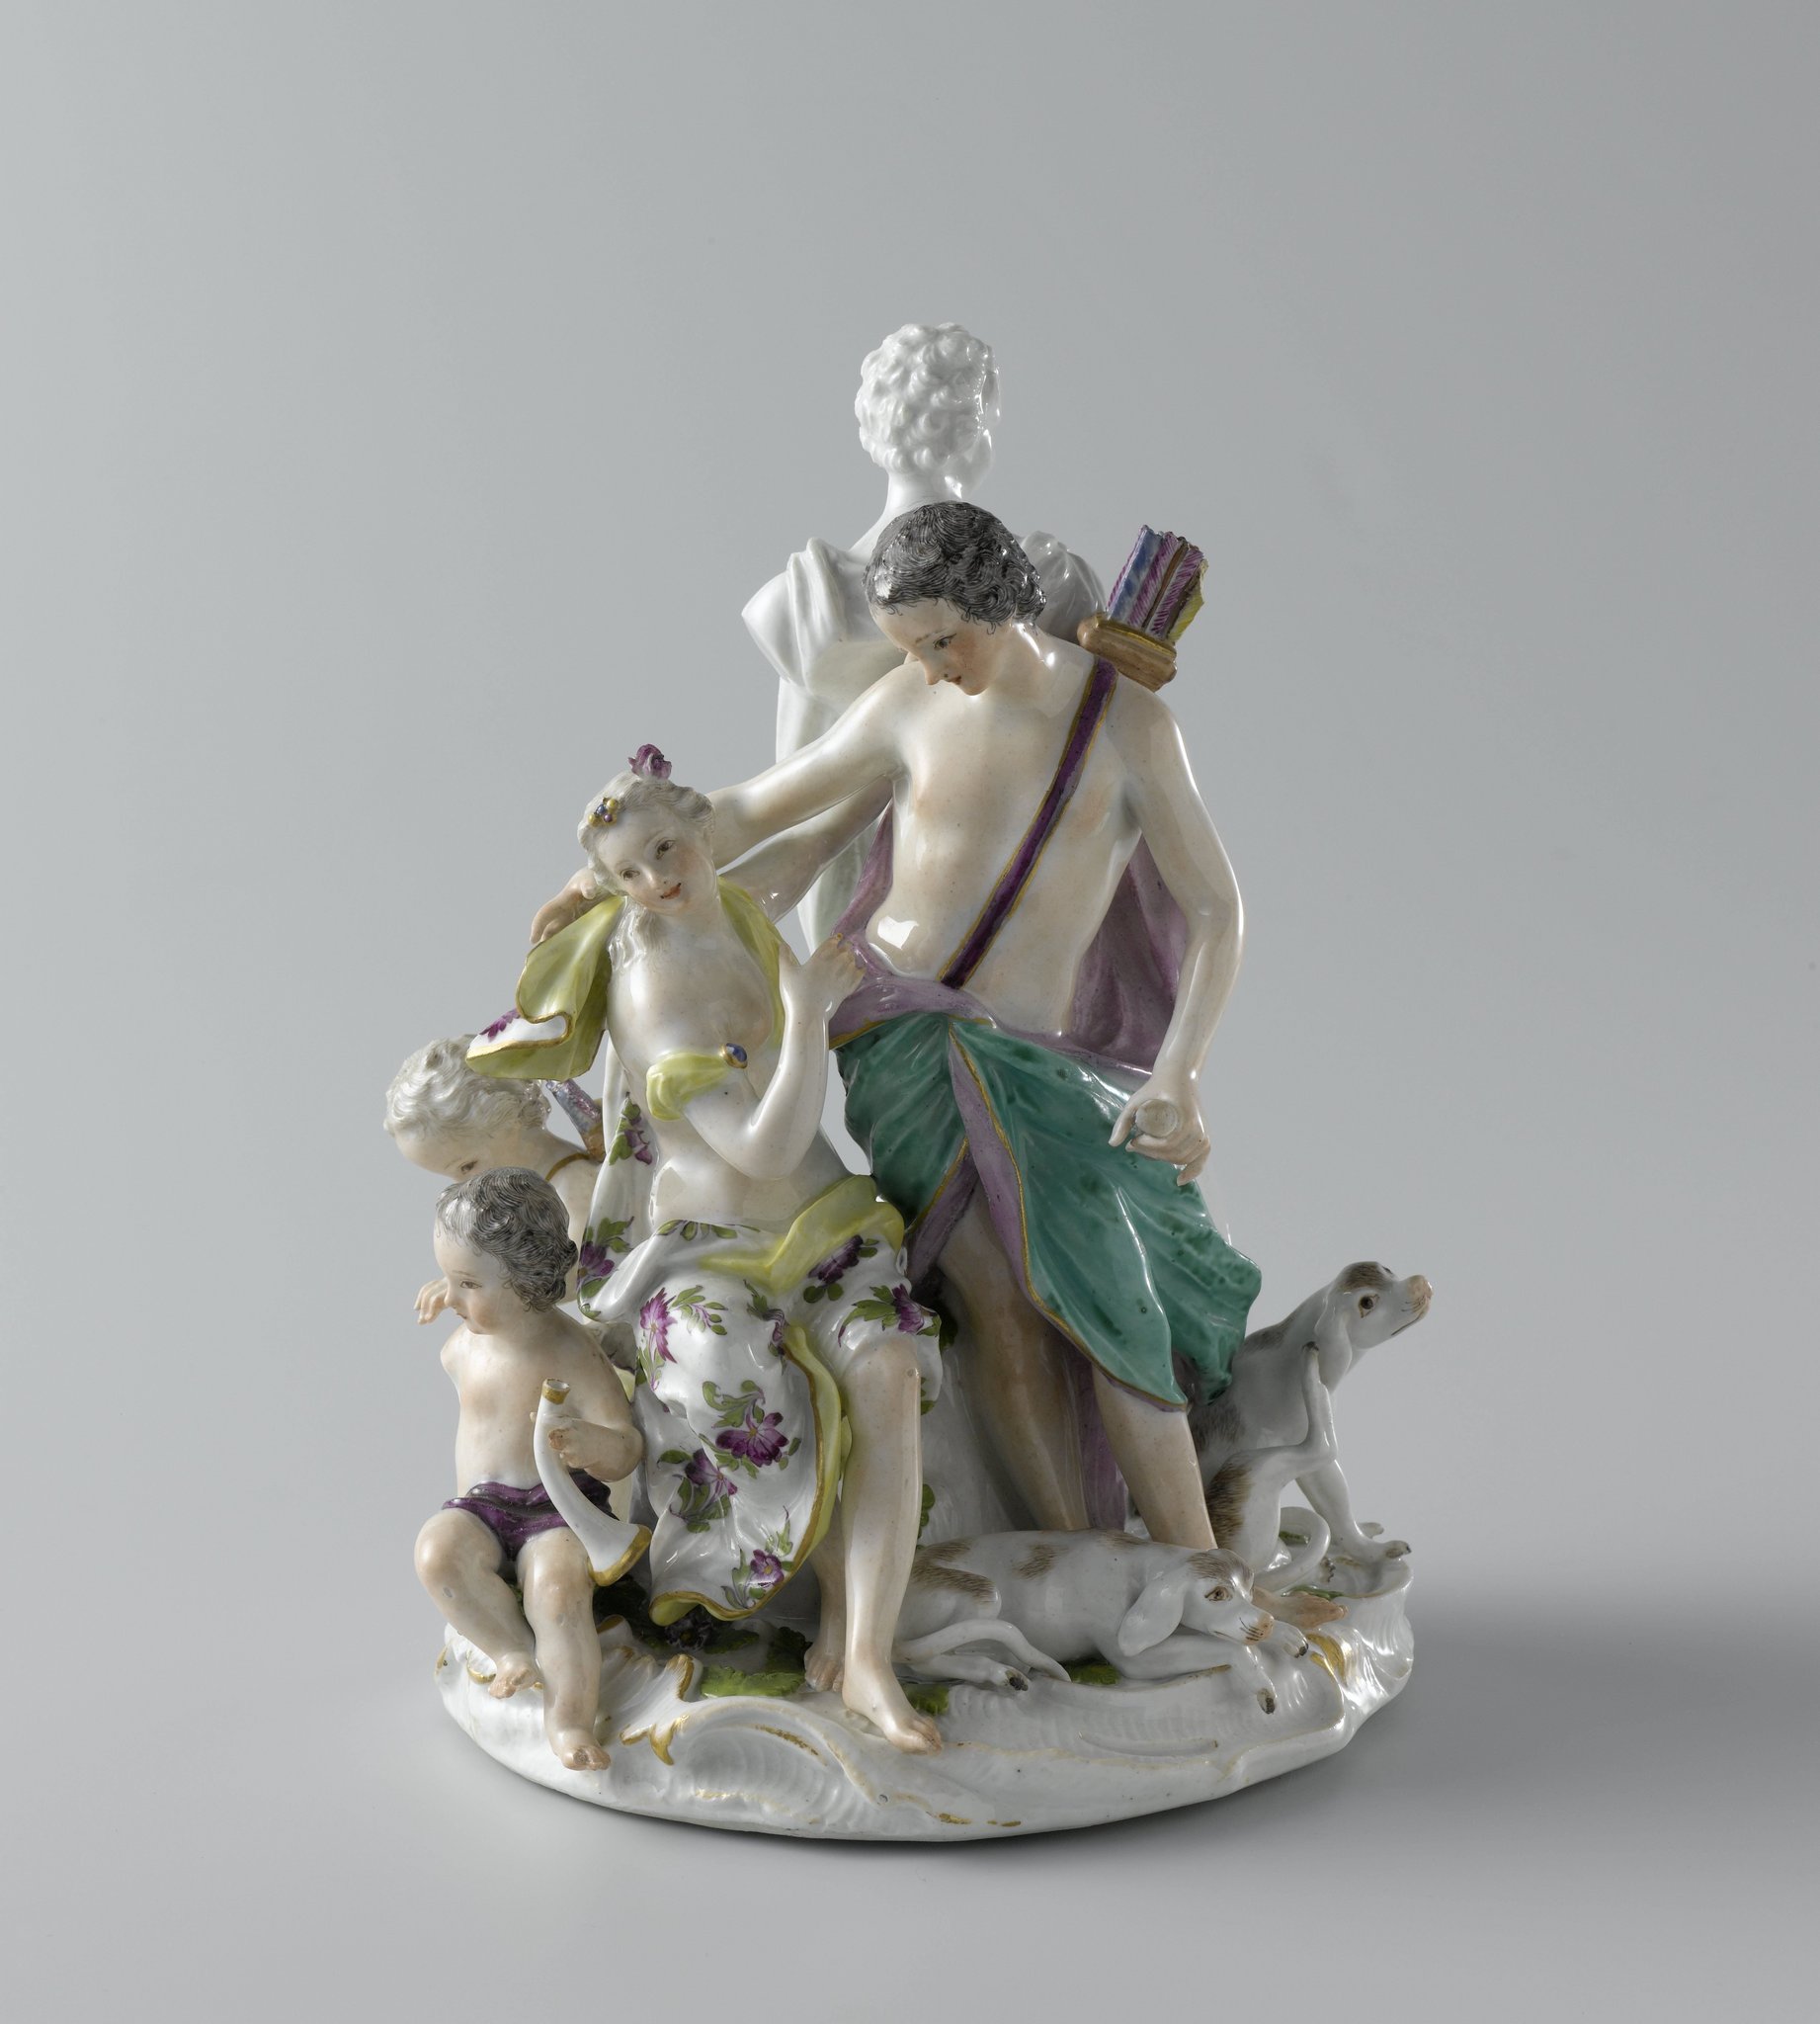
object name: figure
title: Apollo en Diana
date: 1760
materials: porcelain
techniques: painted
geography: meissen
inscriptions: factory mark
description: Apollo and Venus. Porcelain Meissen, c. 1760. J.B.A.M. Westerwoudt bequest, 1907.